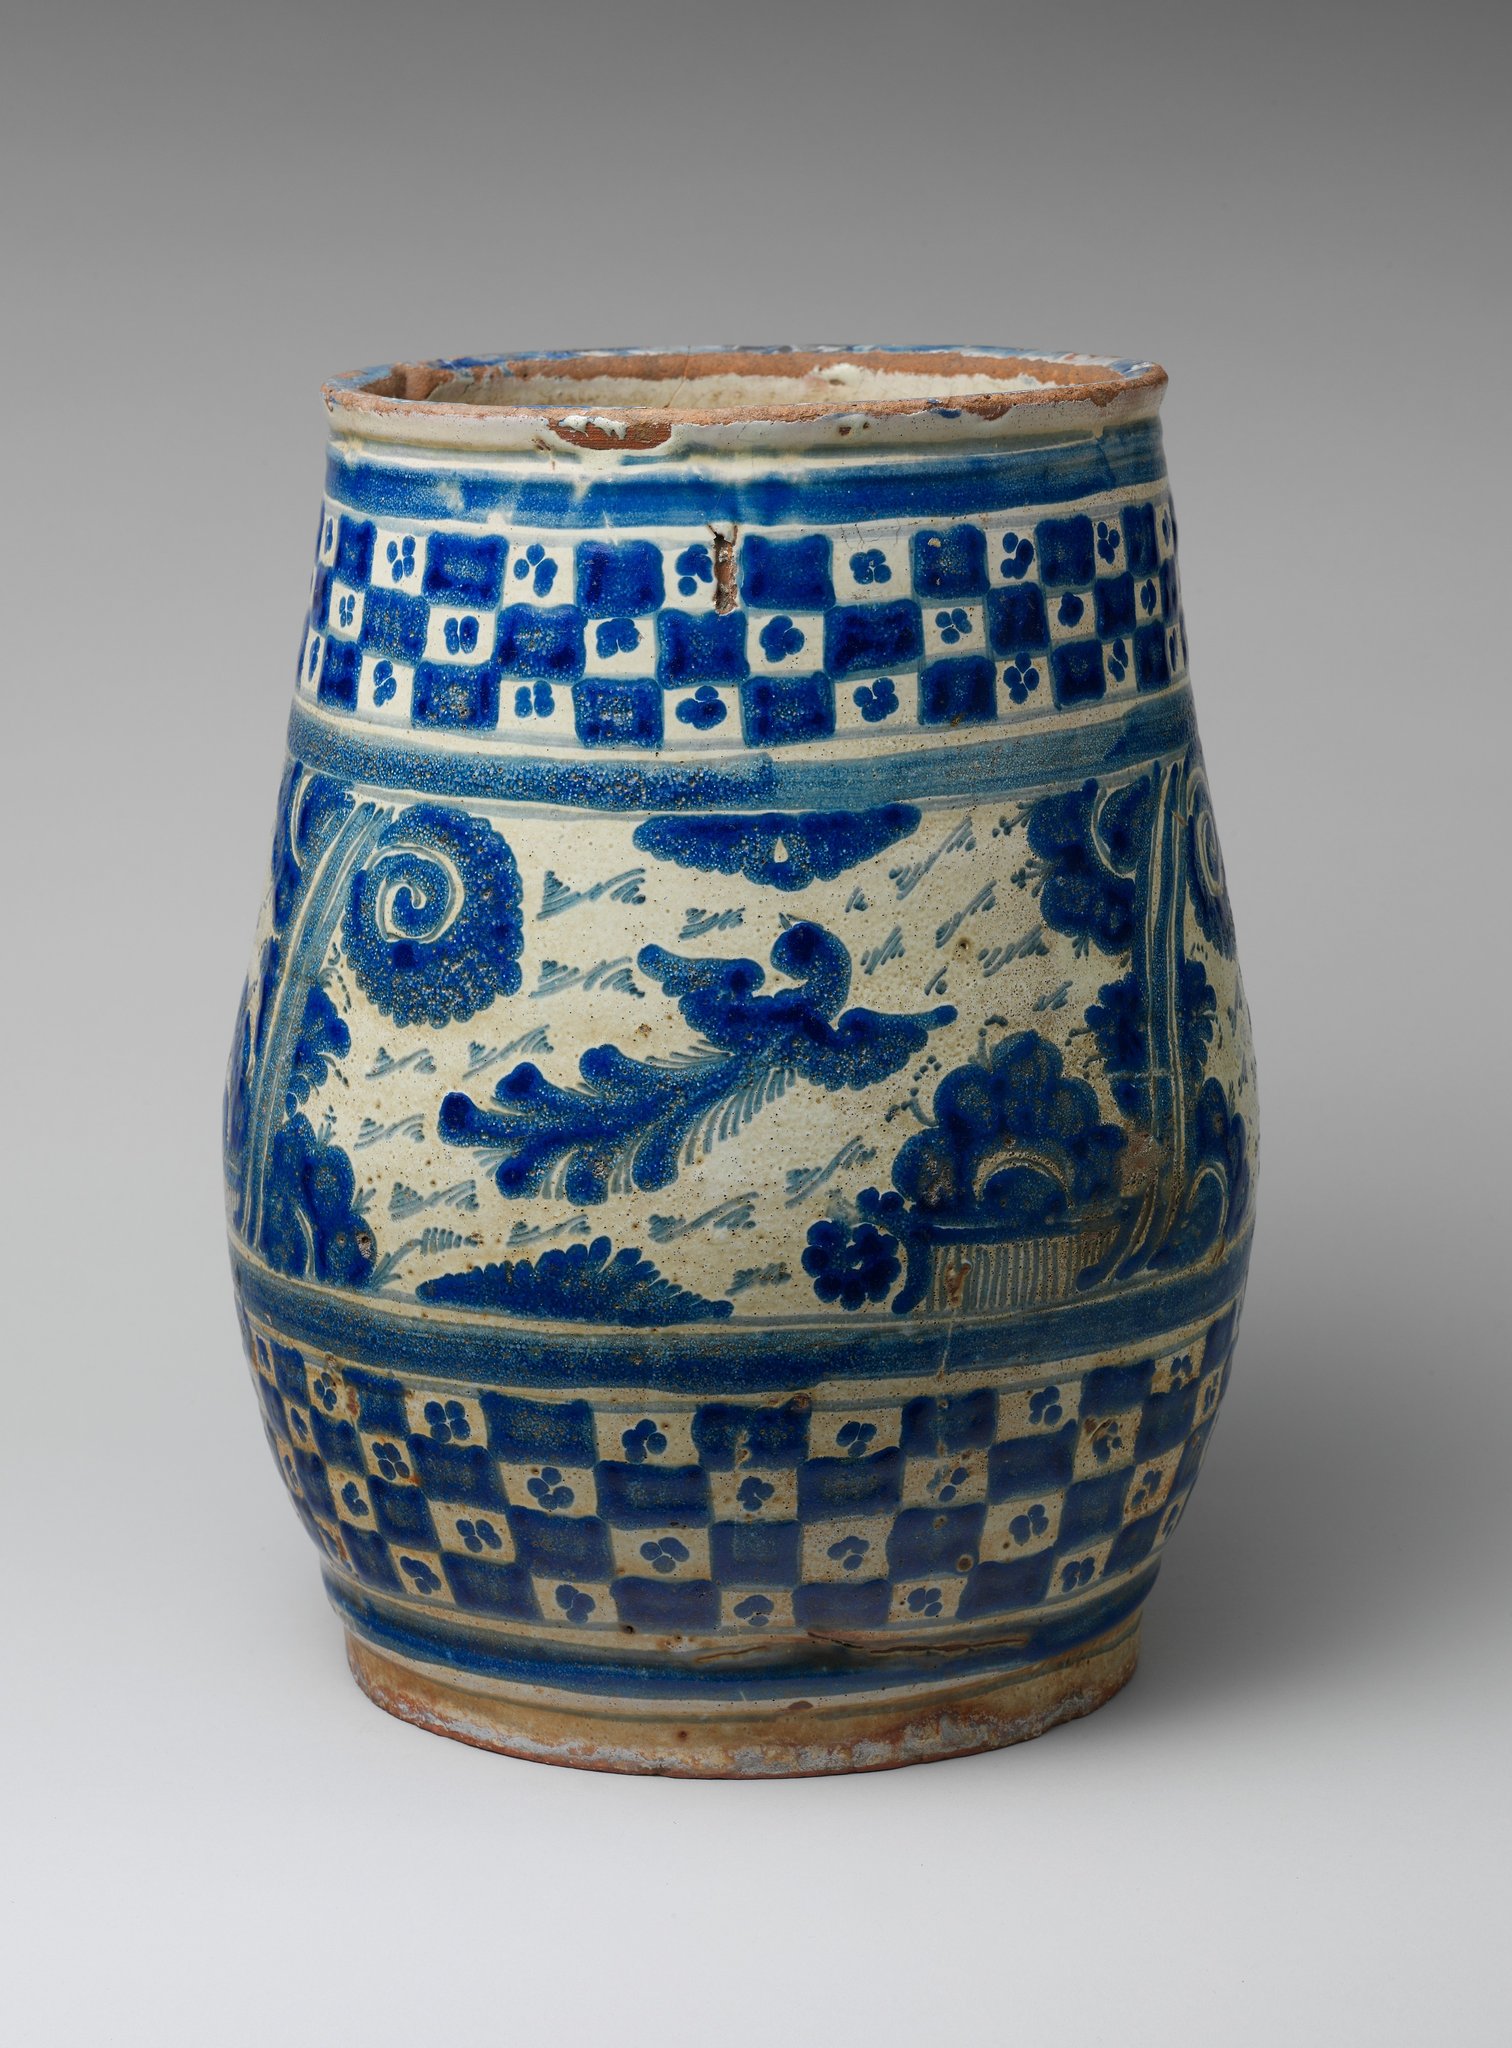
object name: flower pot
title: Barrel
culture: mexican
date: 1750-1780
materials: earthenware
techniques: glazing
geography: mexico